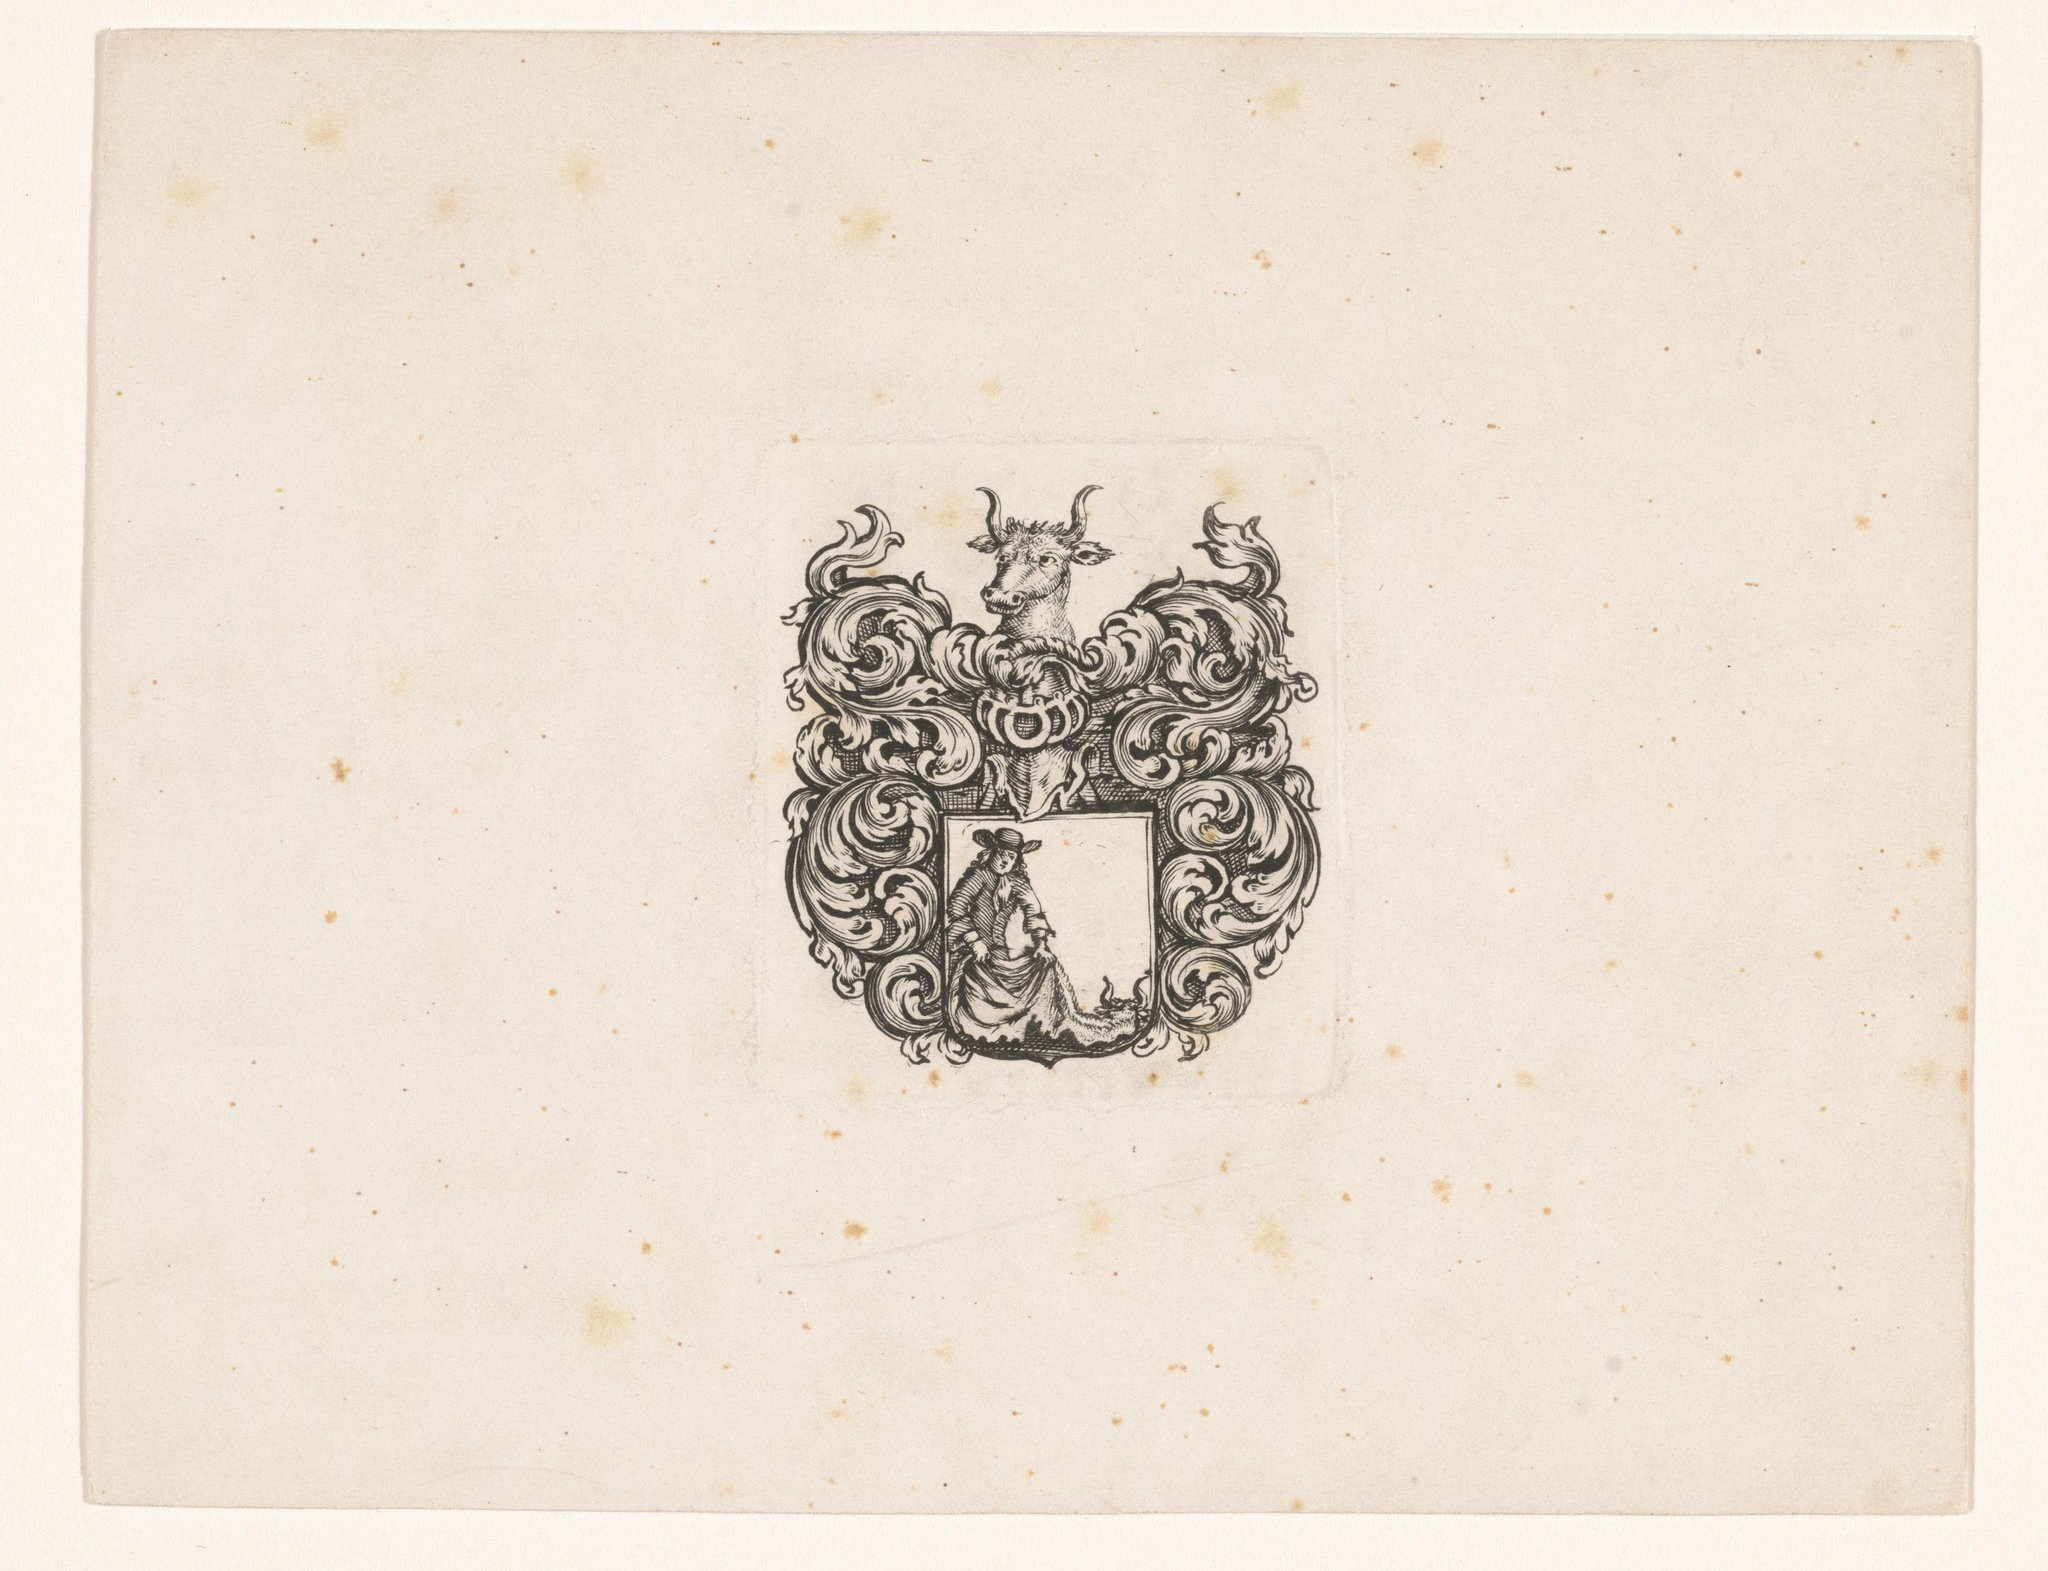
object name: print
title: Wapen van het Amsterdamse looiersgilde (?)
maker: Anonymous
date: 1650-1750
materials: paper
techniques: engraving, etching